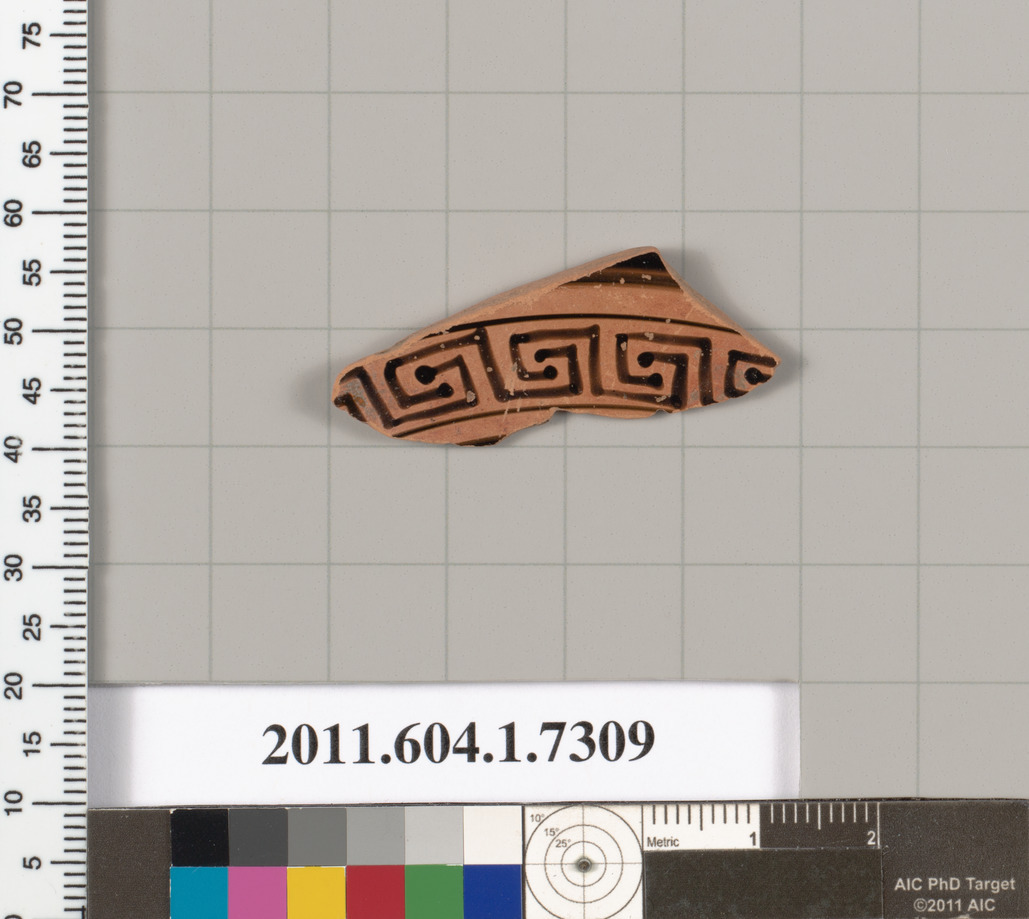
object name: kylix fragment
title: Terracotta fragment of a kylix (drinking cup)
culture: greek, attic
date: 500-480 BCE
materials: terracotta